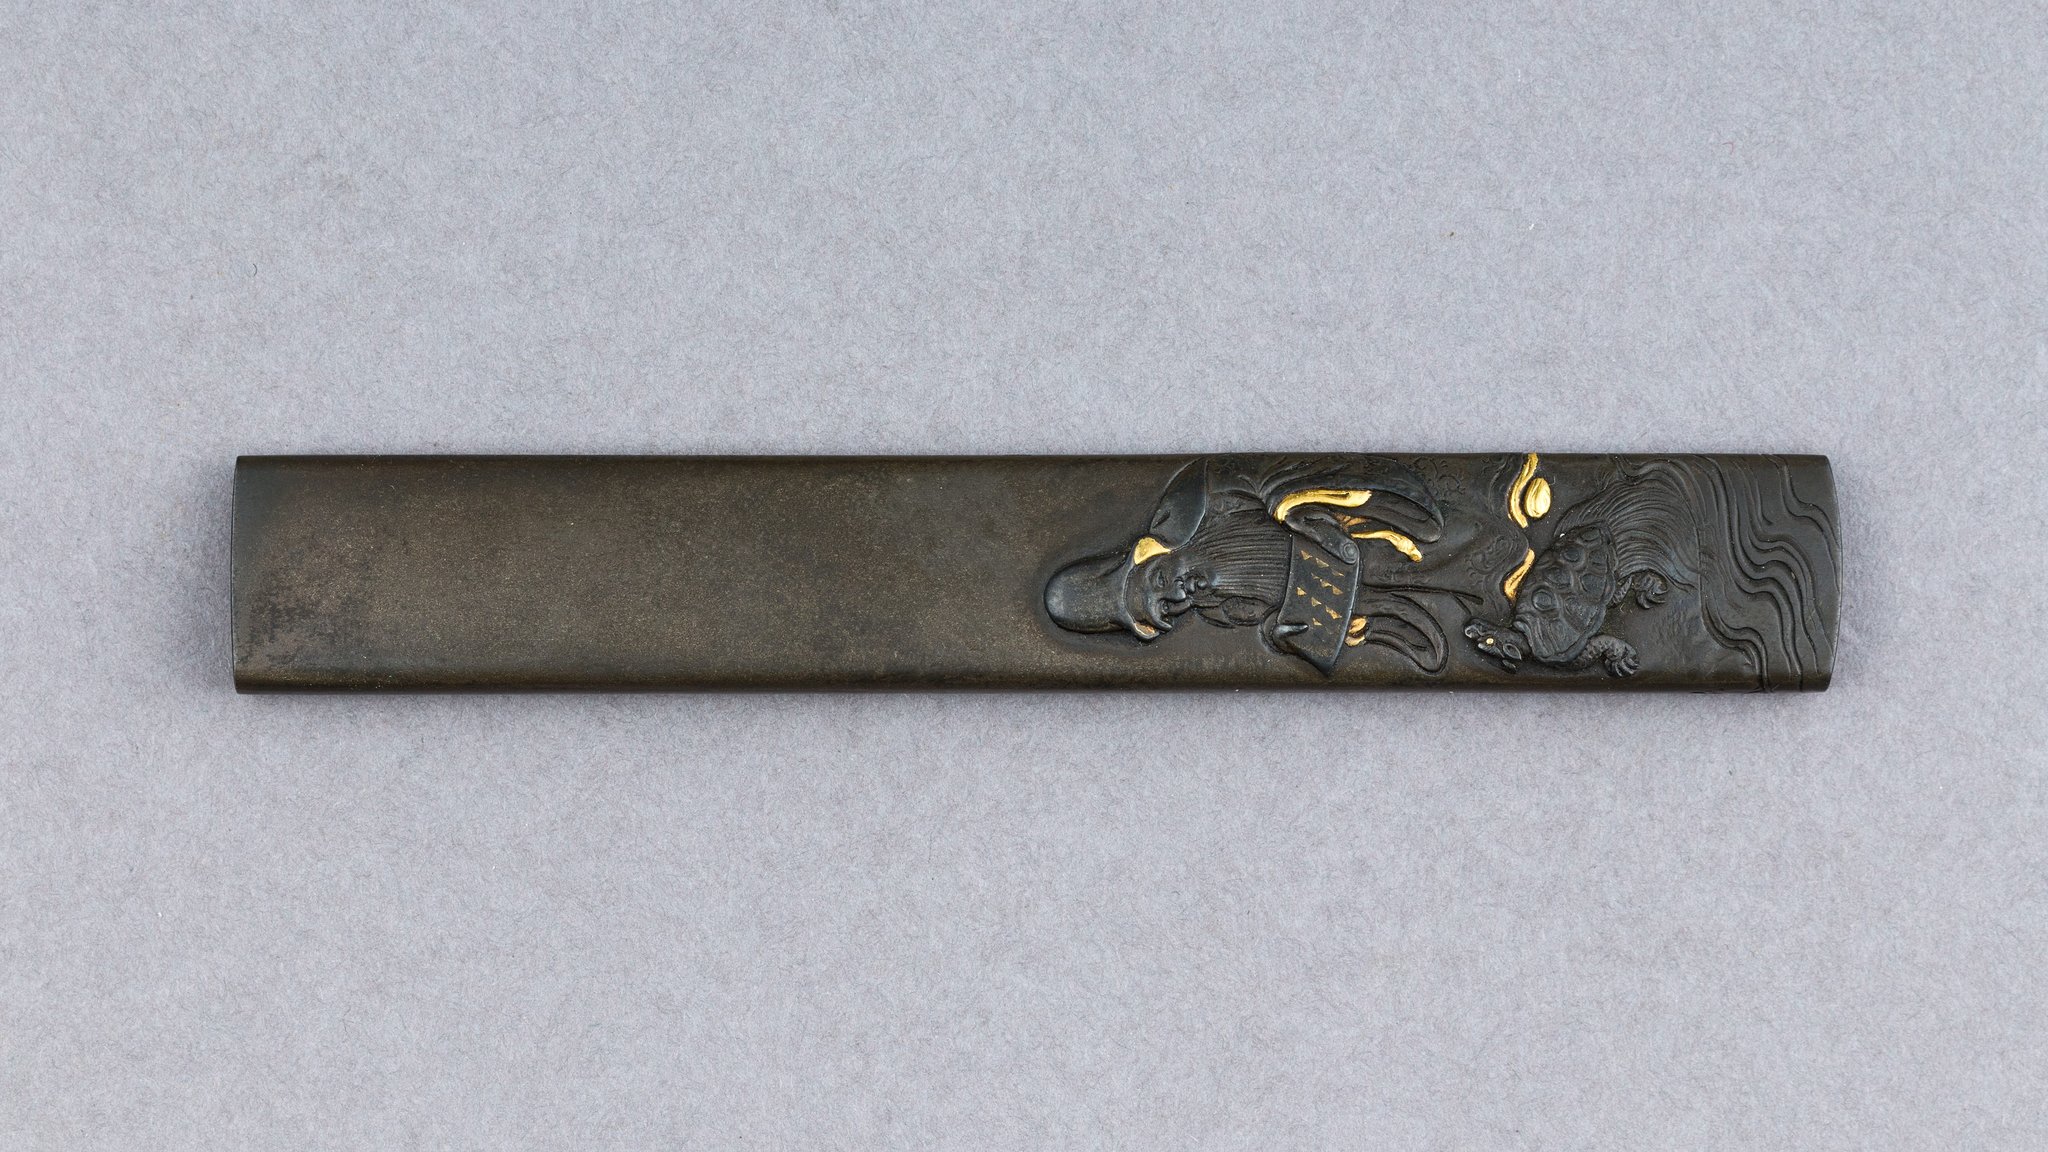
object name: knife handle kozuka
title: Knife Handle (Kozuka)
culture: japanese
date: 1615-1868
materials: silver alloy, gold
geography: japan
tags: animals,men